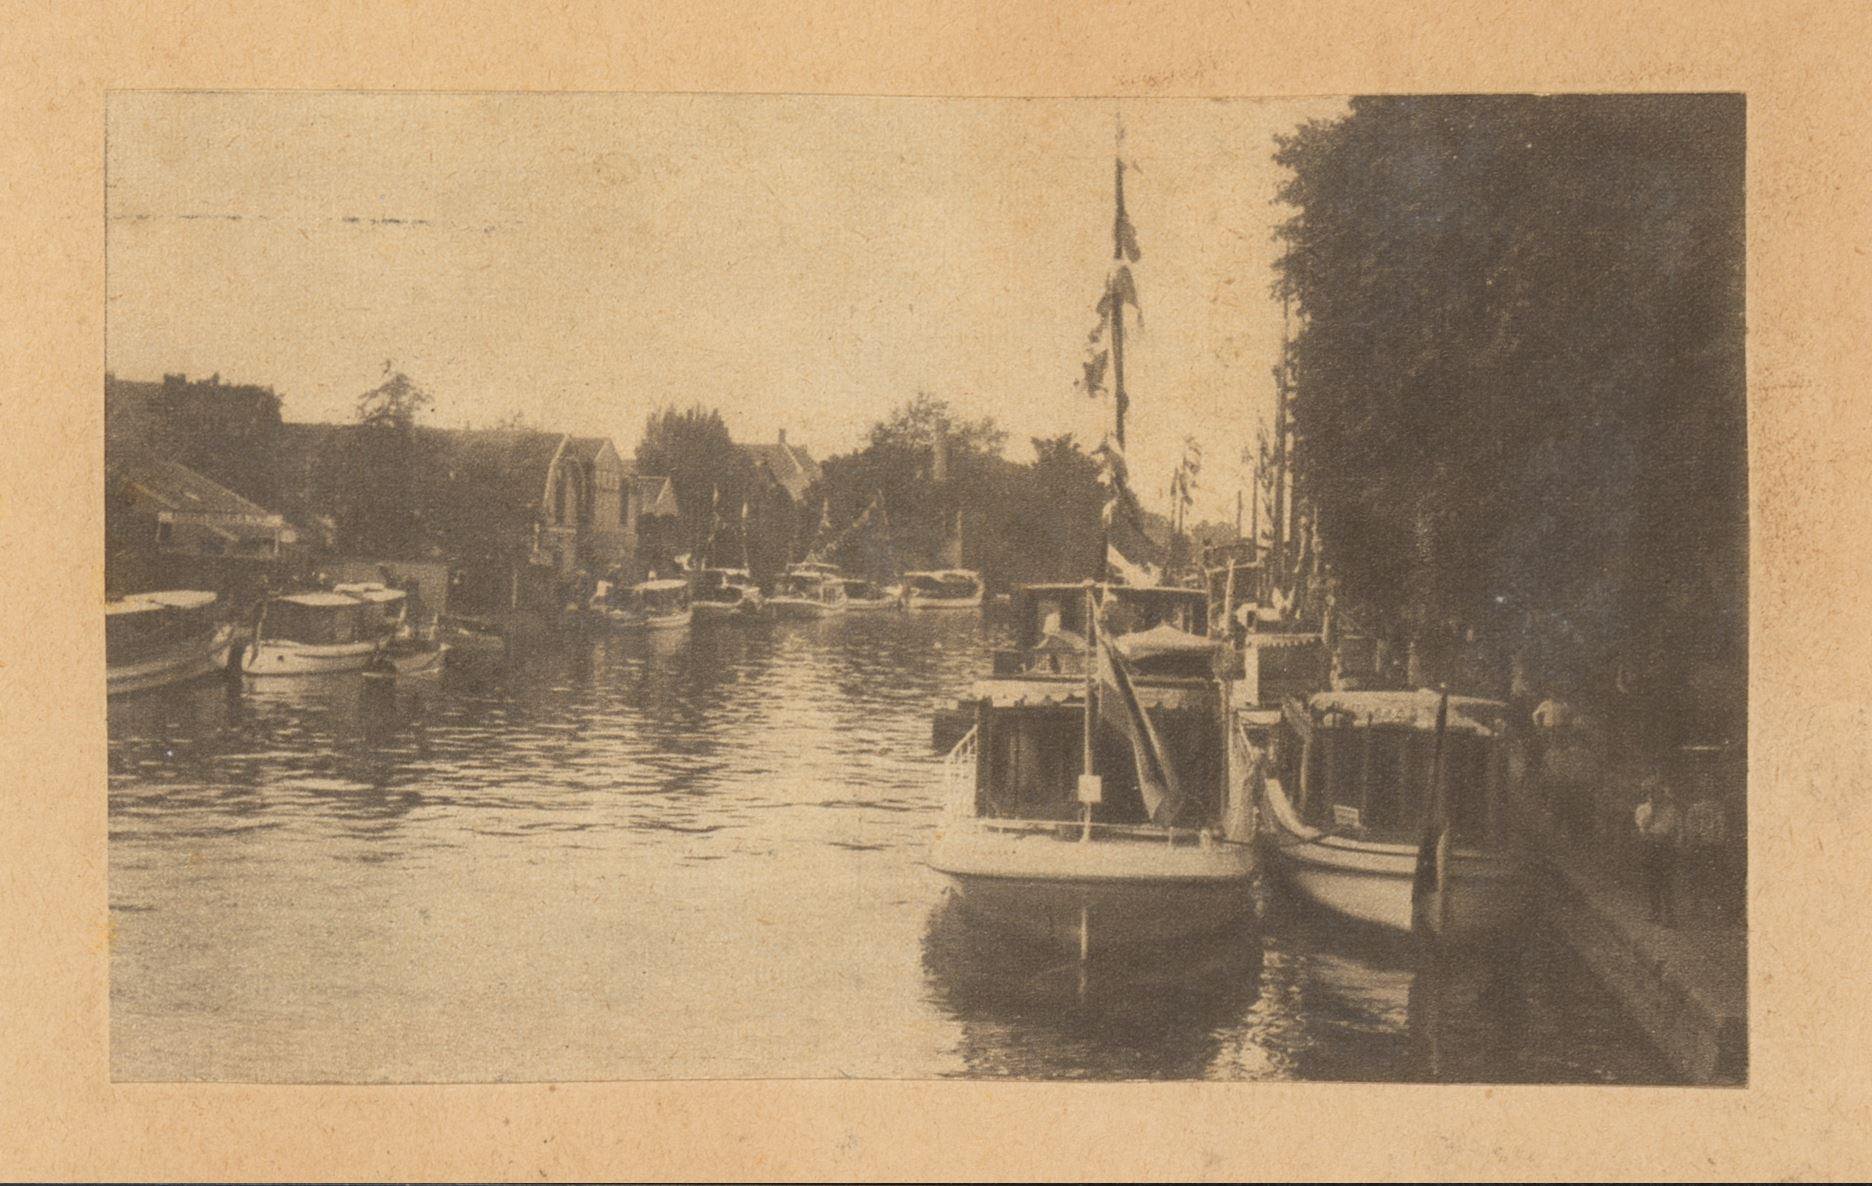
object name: photograph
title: Plezierboten op een vaart, vermoedelijk in Nederland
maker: Anonymous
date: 1900-1920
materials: paper, ink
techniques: rotogravure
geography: netherlands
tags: canal, ships (in general), netherlands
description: Onderdeel van Familiealbum met foto's van een familie in de voormalige kolonie Nederlands-Indië en van een suikerfabriek in Purworejo.